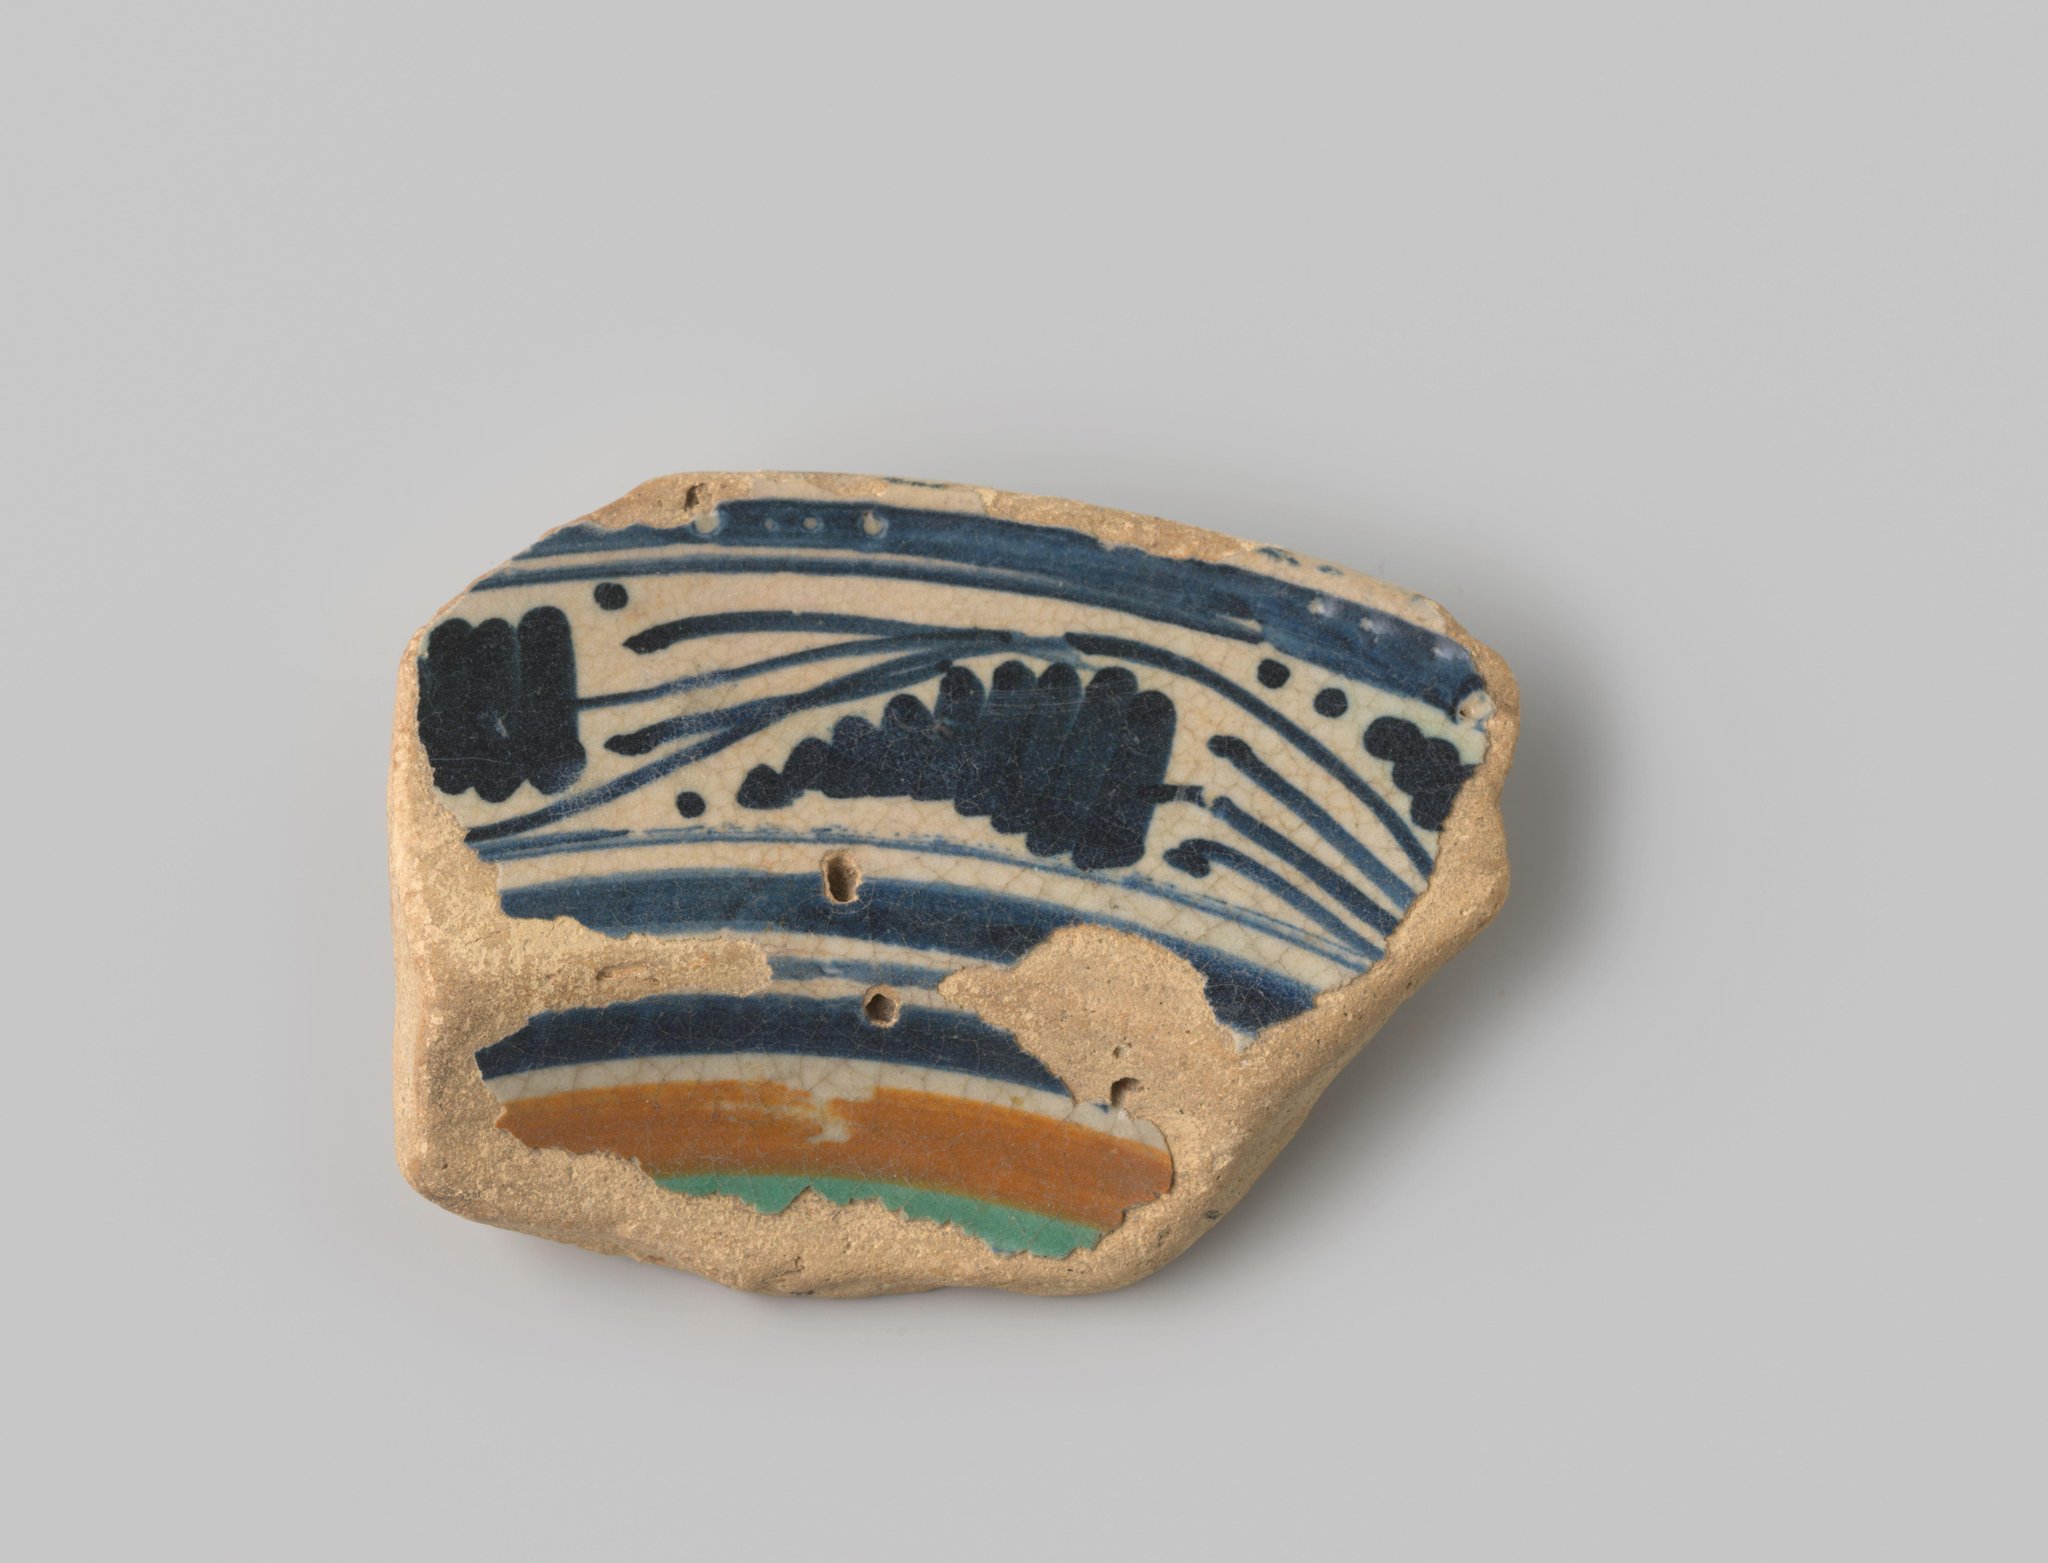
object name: sherd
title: Fragment van een schotel met geelbakkende scherf, met aan de voor- en achterzijde wit glazuur, waarop aan de voorzijde in blauw, oranje en groen strepen en bloemvormen zijn geschilderd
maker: Anonymous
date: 1200-1899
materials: earthenware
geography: italy